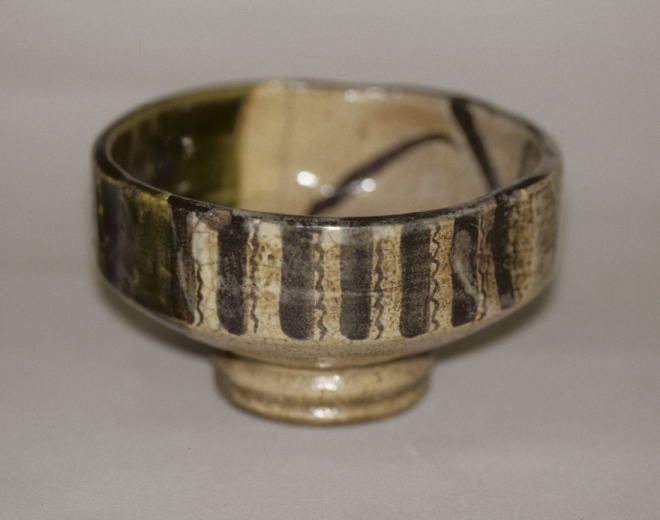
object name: teabowl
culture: japanese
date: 1601-1700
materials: clay, glaze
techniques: overglaze